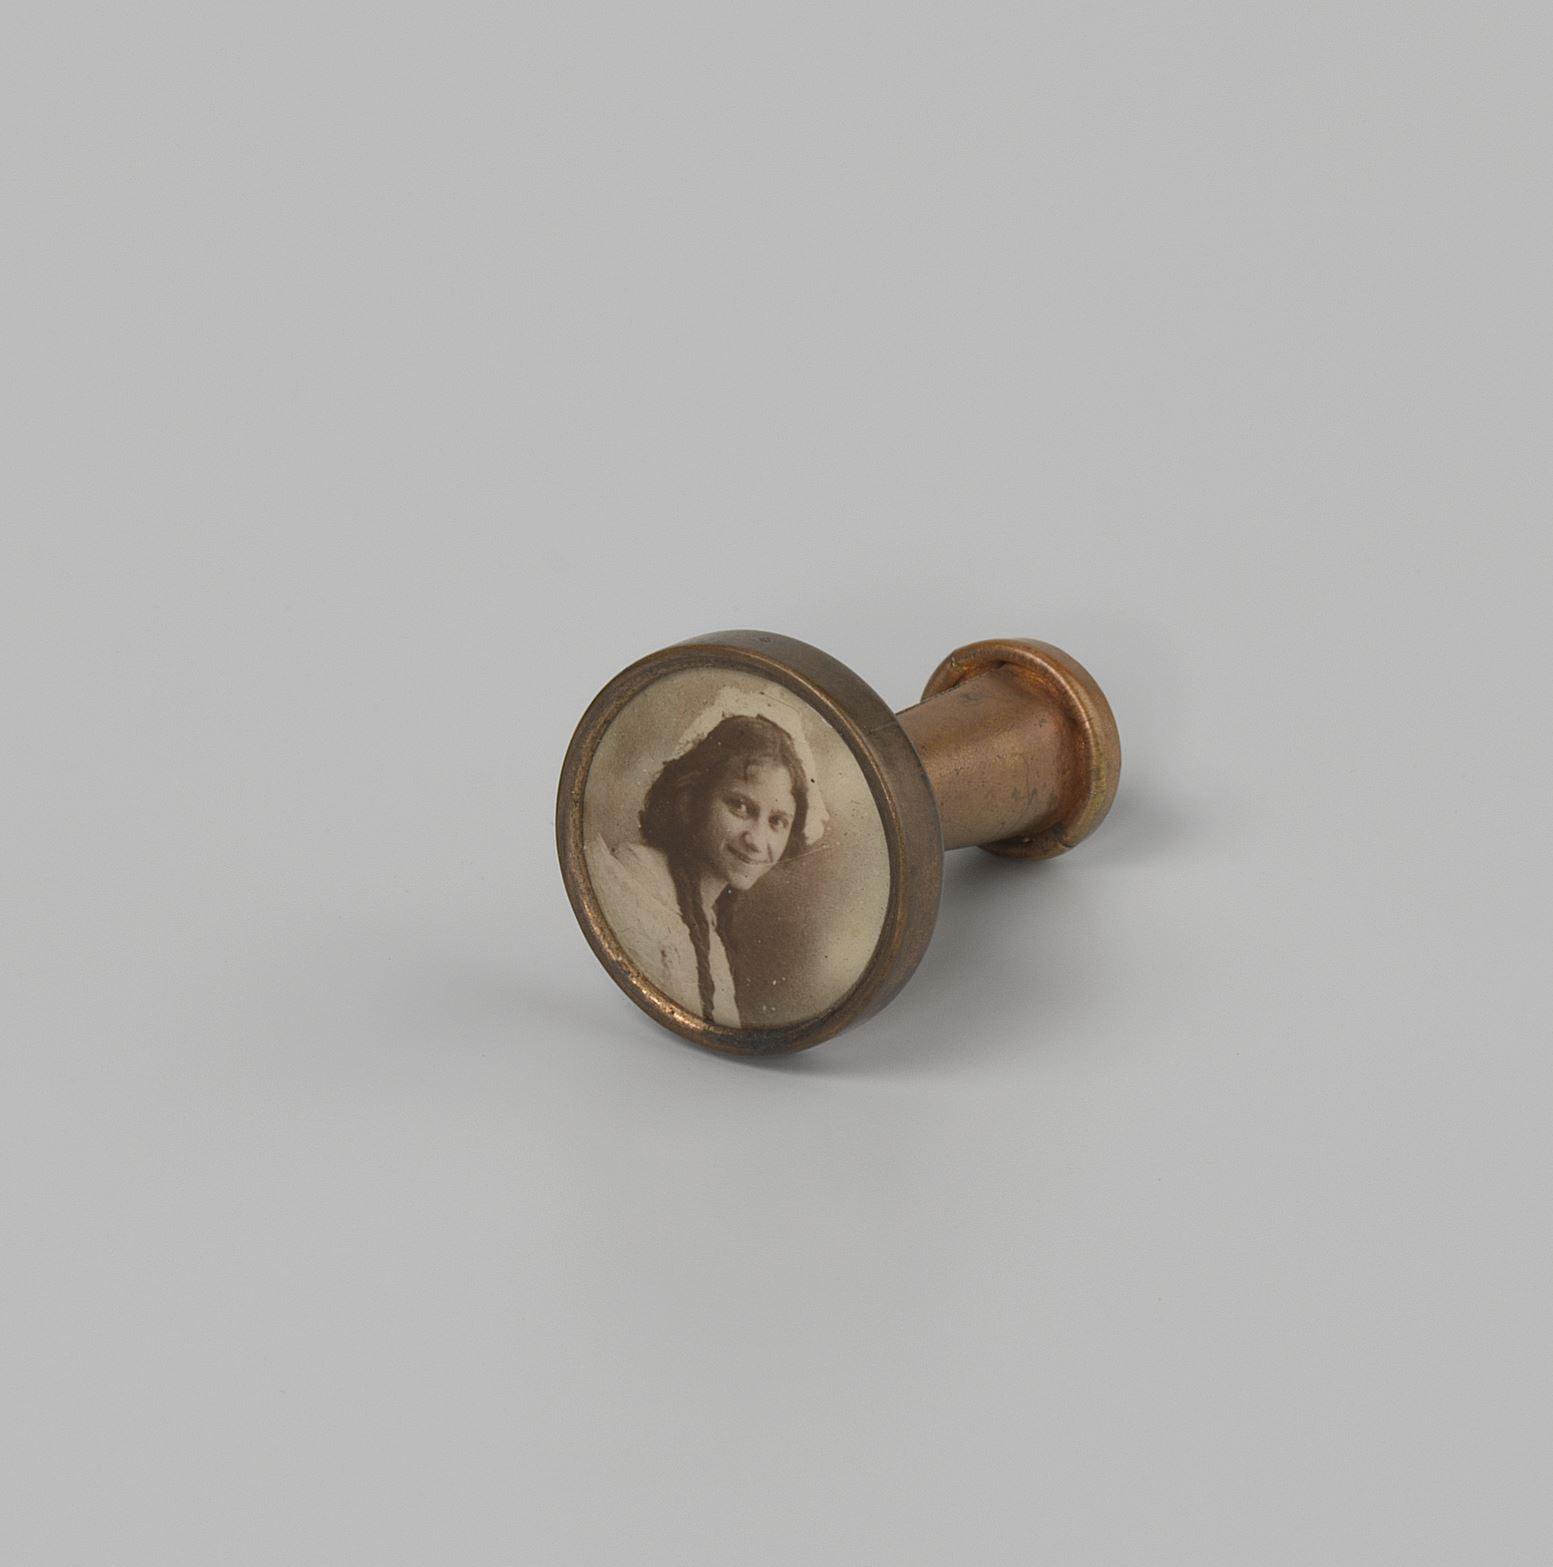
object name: cuff link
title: Manchetknoop met foto van jonge vrouw met neergeslagen blik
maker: Anonymous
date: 1900-1920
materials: brass, photographic support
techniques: photography